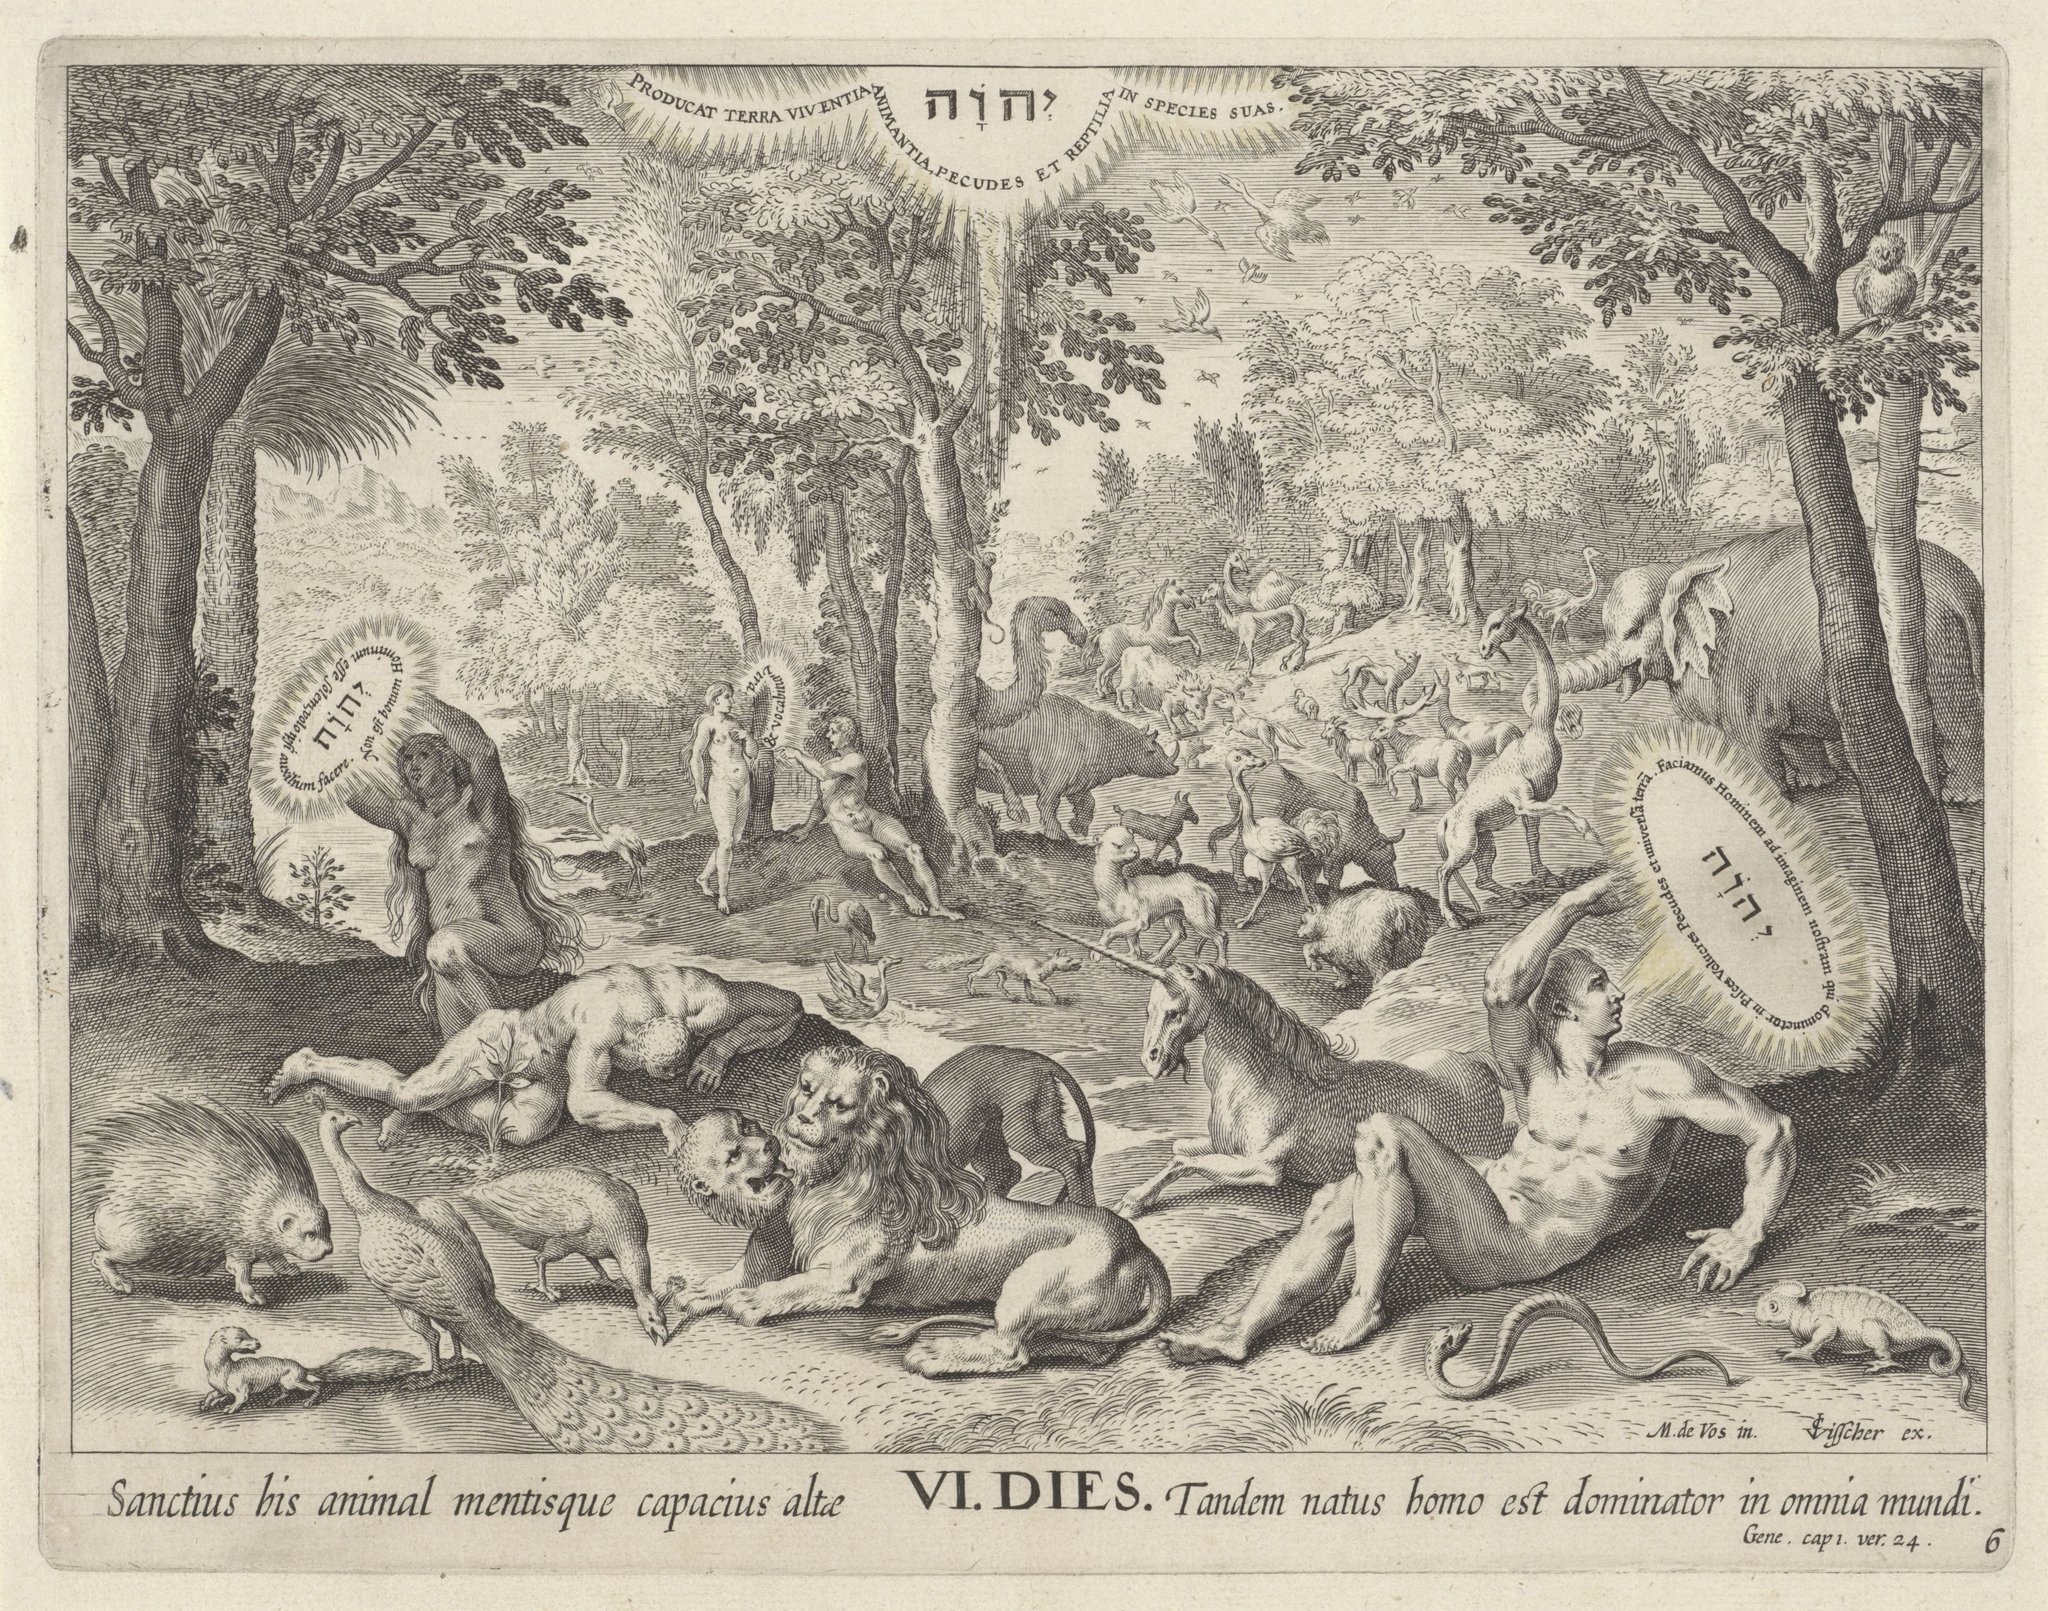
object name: print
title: Schepping van de wereld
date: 1588-1600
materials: paper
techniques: colour, engraving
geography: amsterdam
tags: creation of man; the garden of eden (genesis 1:26 - 2), unicorn, animals, creation of eve, tetragram (in roman or hebrew script) ~ symbol of god the father, beasts of prey, predatory animals: lion, creation of land-animals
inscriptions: collector's mark: Lugt 2228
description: Ten midden van de dieren worden Adam en Eva geschapen door God de Vader in de vorm van een tetragram. Rechts op de voorgrond buigt God zich over Adam; links wordt Eva uit de rib van Adam geschapen. In het midden twee leeuwen, een eenhoorn en andere dieren. In het midden op de achtergrond geeft God Eva aan Adam. Op de zesde dag van de schepping schiep God de dieren van het land en Adam en Eva. De prent heeft een Latijns onderschrift.